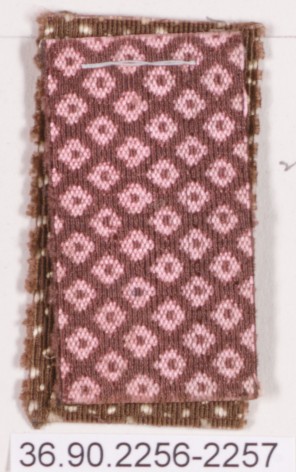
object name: piece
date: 1801-1900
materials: silk